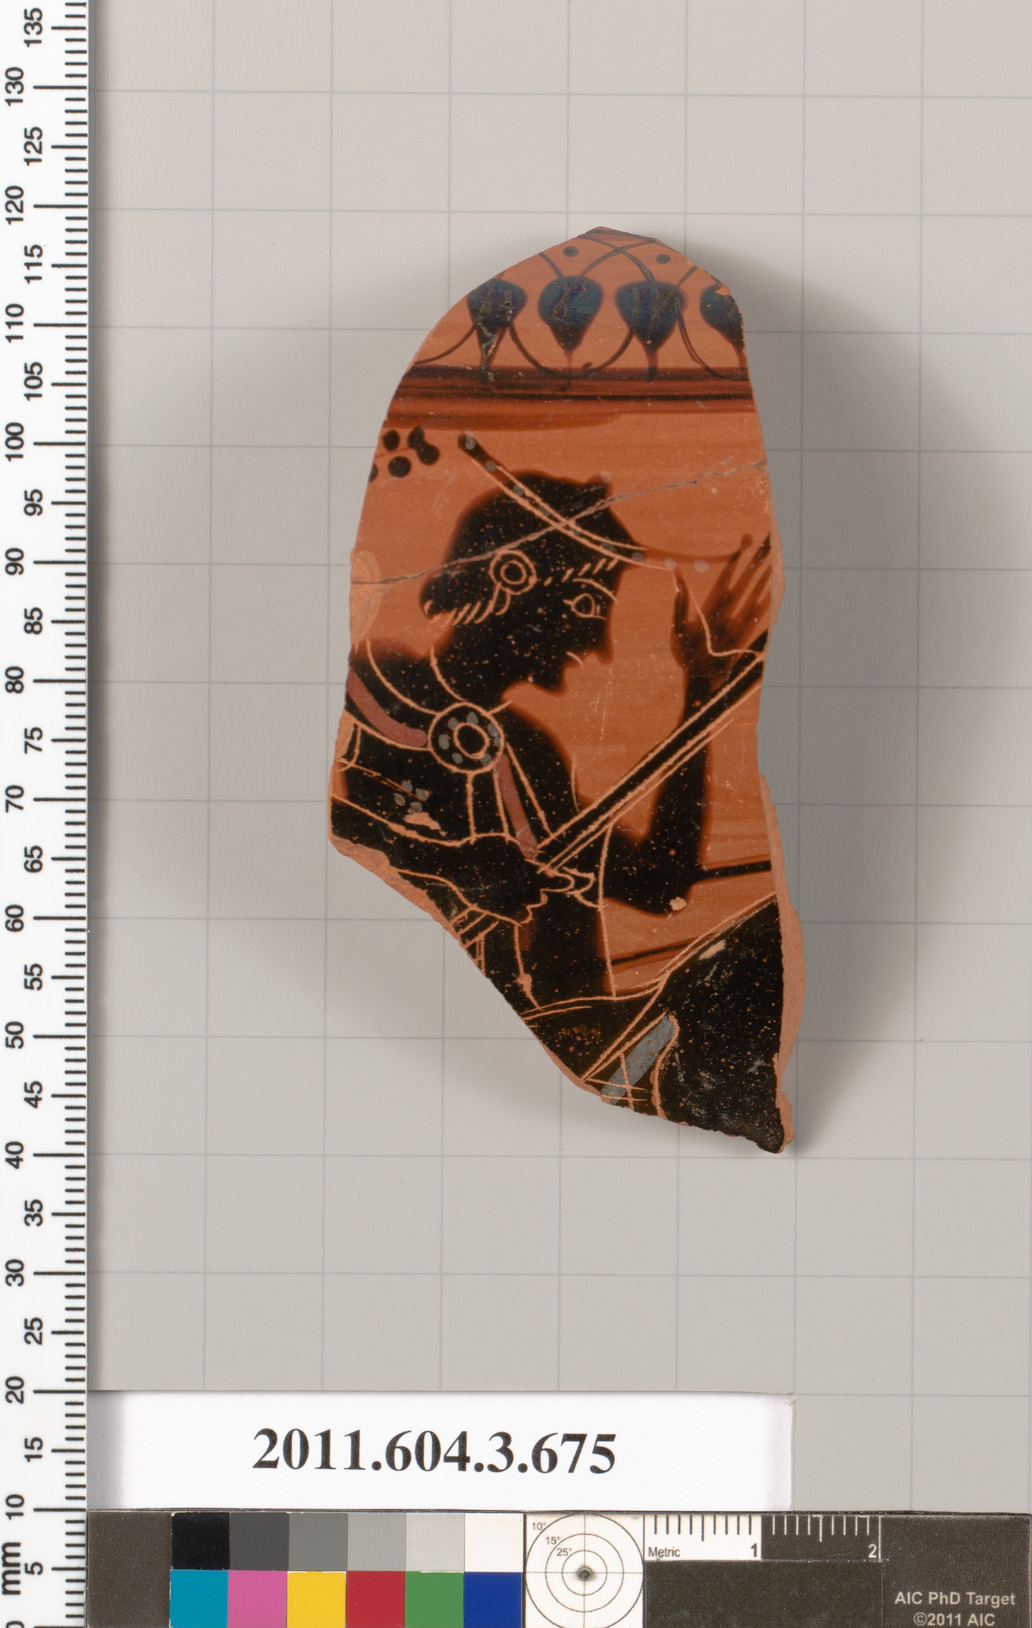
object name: stamnos fragment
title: Terracotta fragment of a stamnos (jar)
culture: greek, attic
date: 510-500 BCE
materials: terracotta